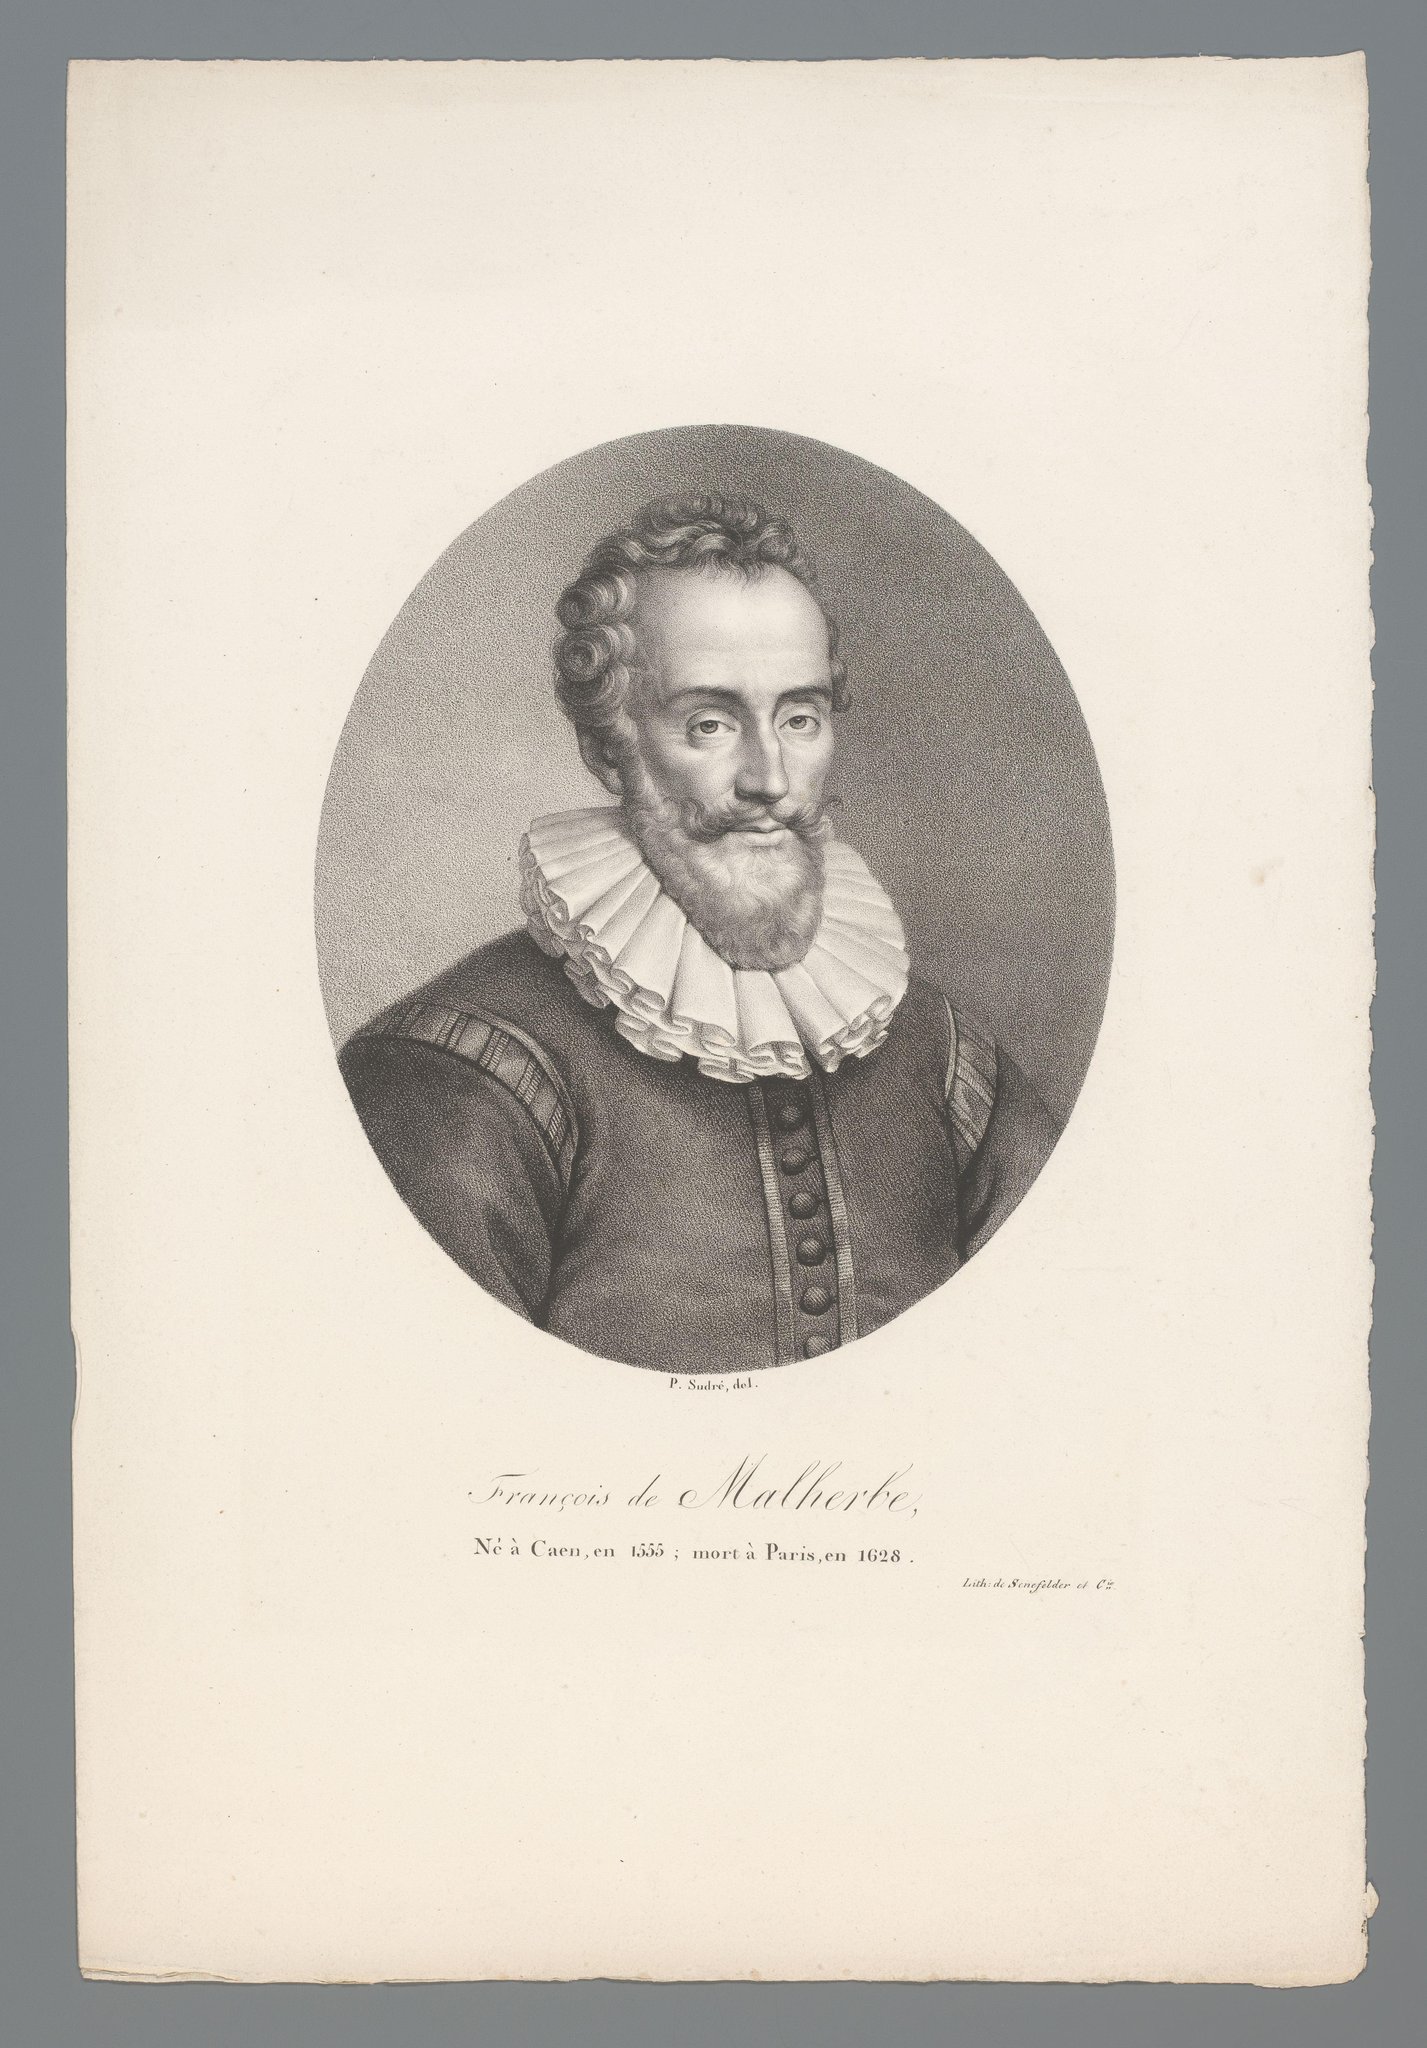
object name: print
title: Le panthéon français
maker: jean pierre sudre (1783-1866)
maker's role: painter, print maker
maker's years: 1783-1866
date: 1820-1827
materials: paper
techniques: lithograph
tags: paris, historical persons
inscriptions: collector's mark: Lugt 2228